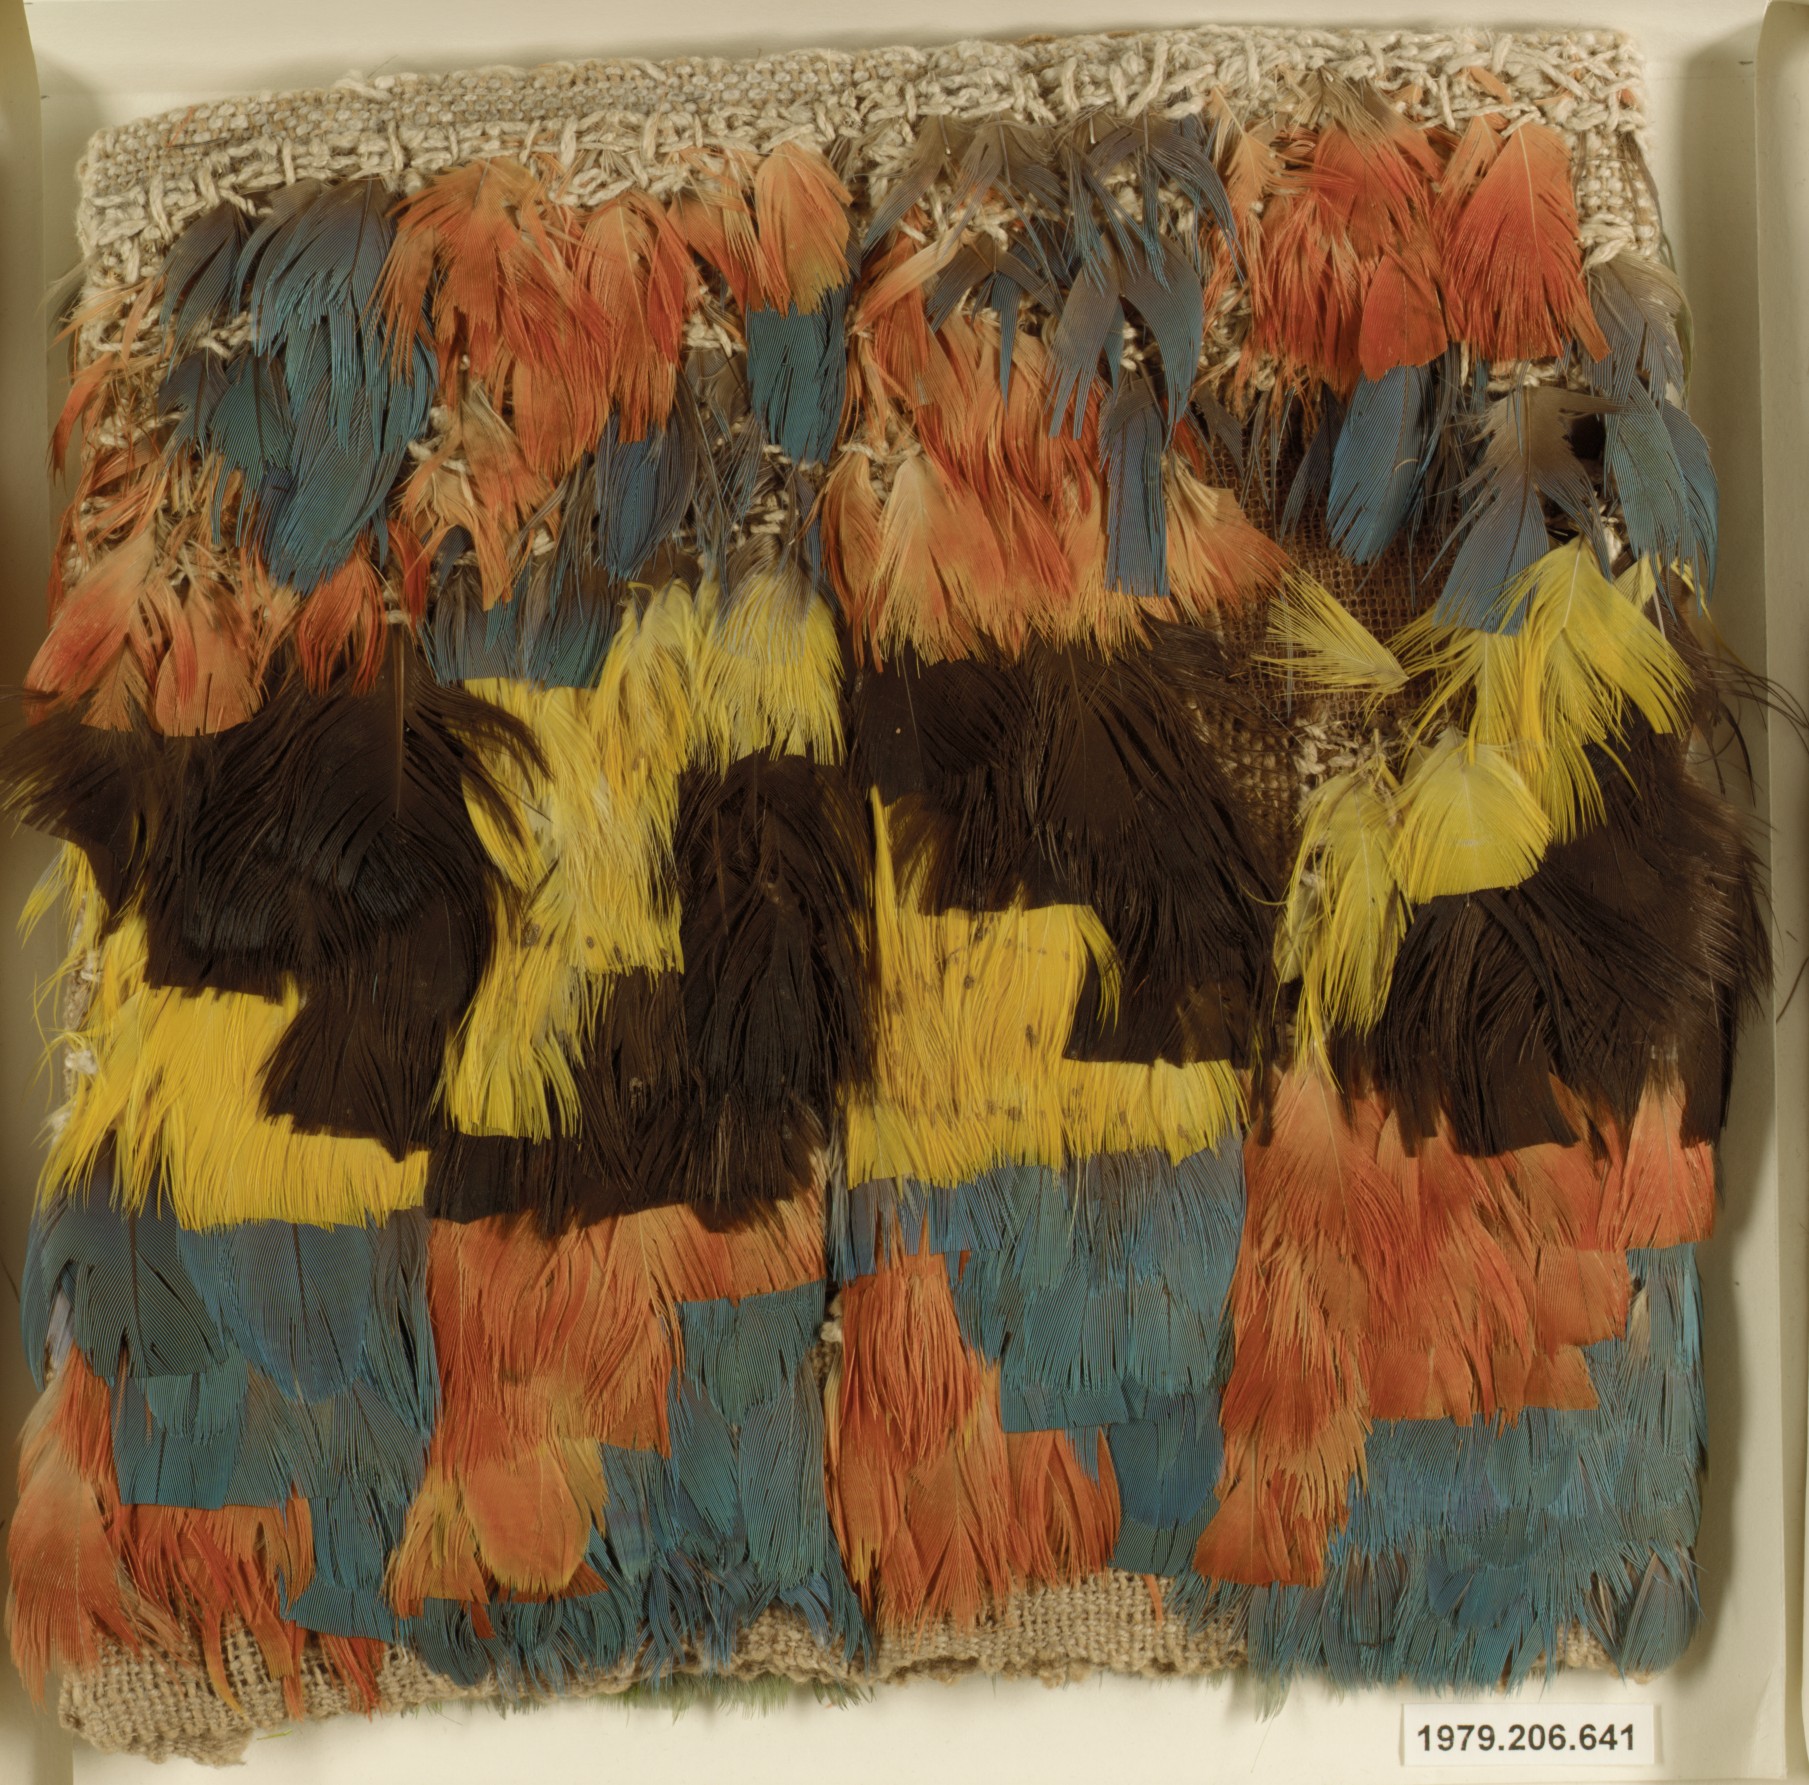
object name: miniature dress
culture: ica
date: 1101-1300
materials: cotton, feather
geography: peru